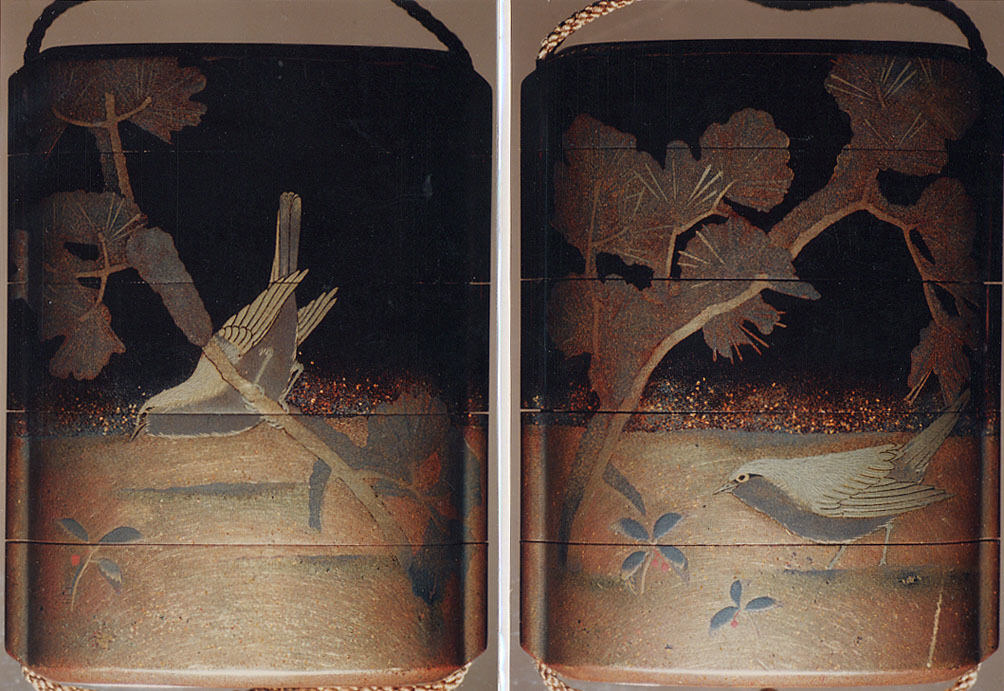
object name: inrō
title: Case (Inrō) with Design of Bird Seated on Snowy Pine Branch (obverse); Bird beside Red Berry Plant (reverse)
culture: japanese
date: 1701-1900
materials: gold, lacquer, silver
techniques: fundame, roiro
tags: birds,plants